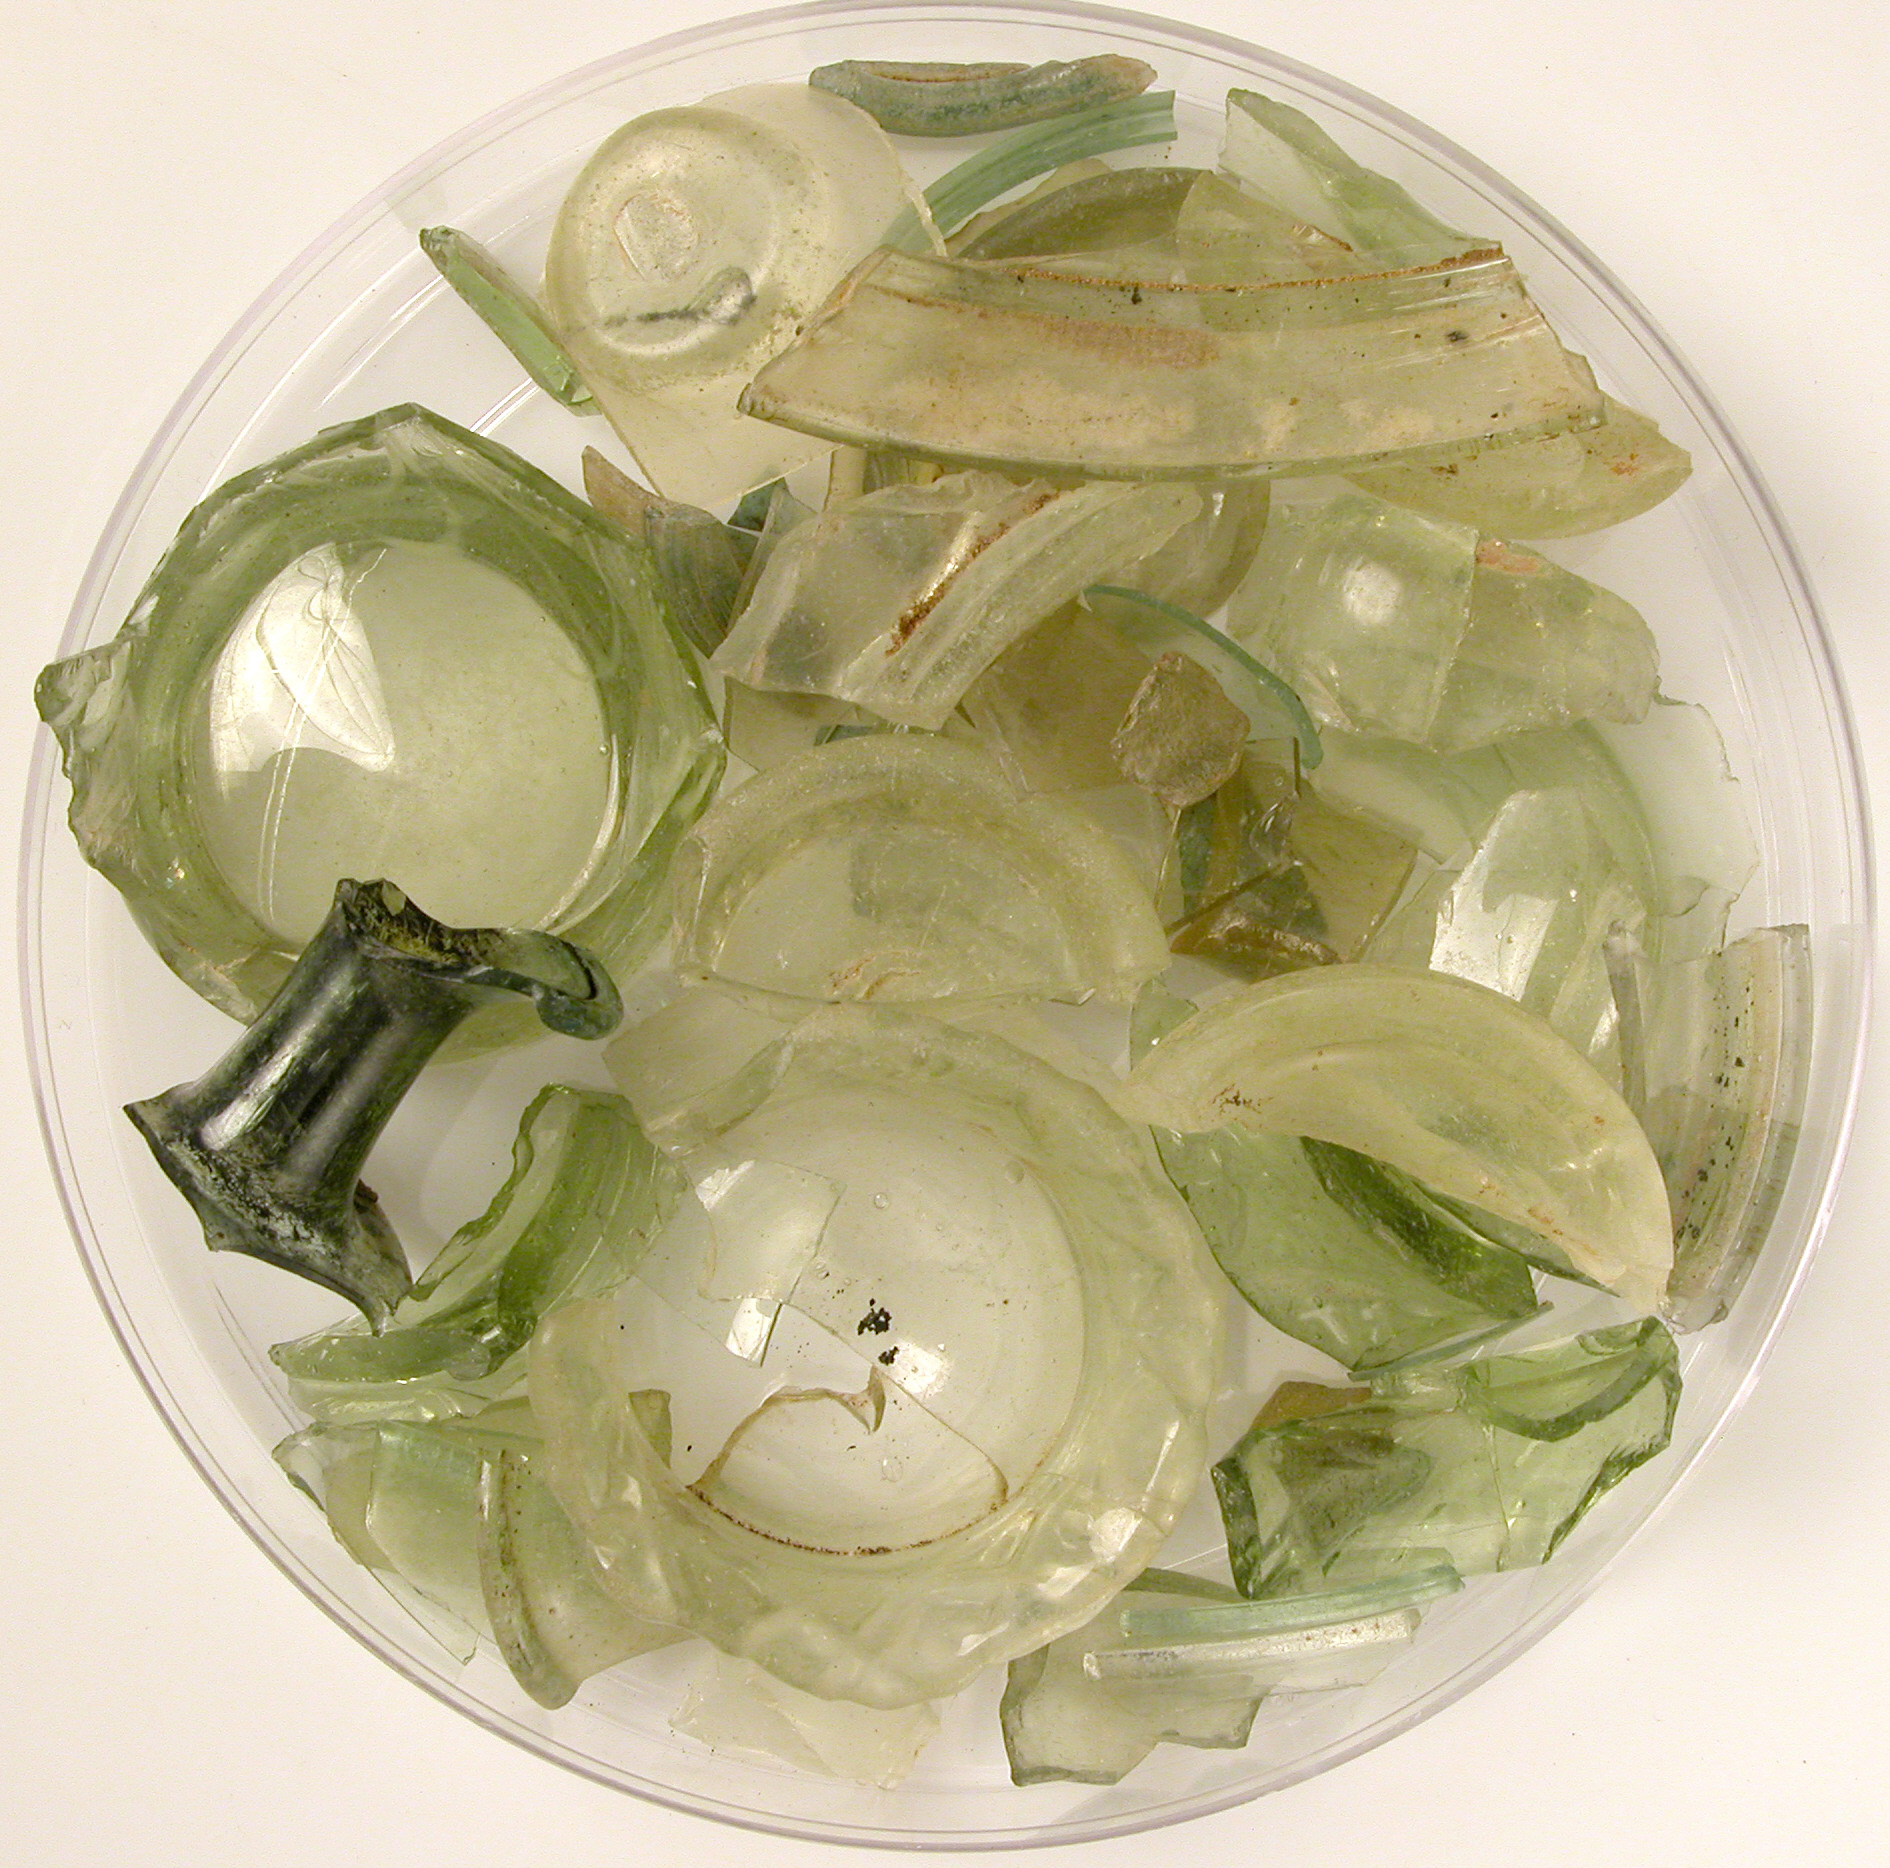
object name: fragment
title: Glass Fragments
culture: coptic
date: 301-700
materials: glass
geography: egypt